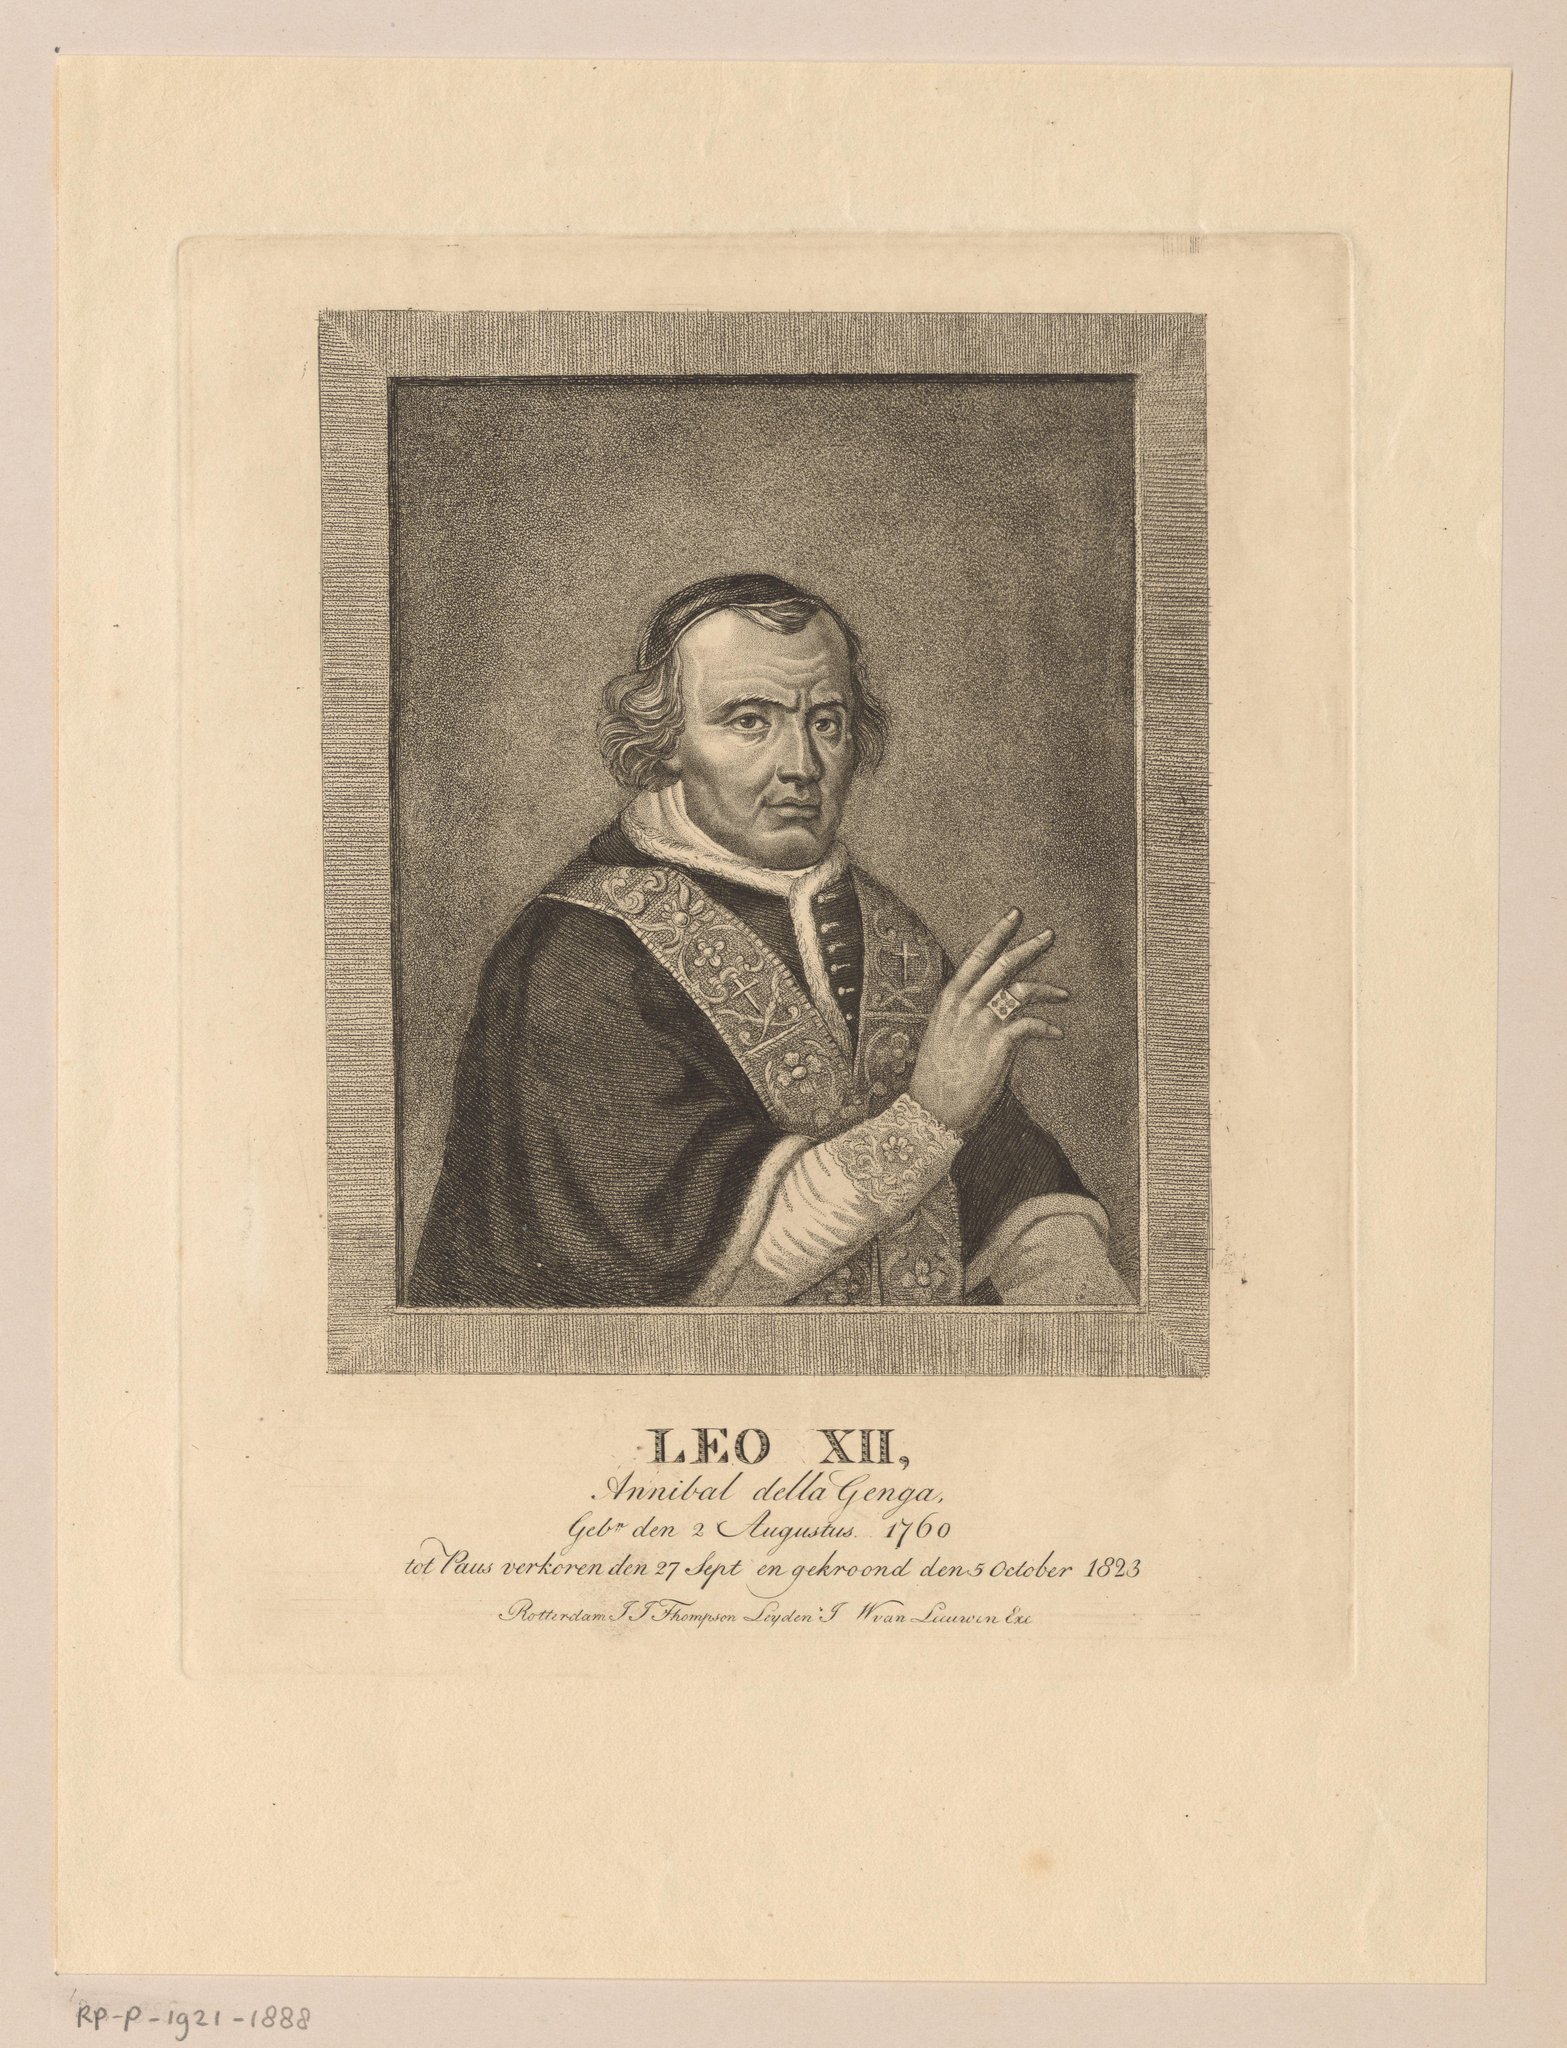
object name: print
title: Portret van Leo XII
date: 1823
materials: paper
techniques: aquatint, etching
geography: netherlands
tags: historical persons, pope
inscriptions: collector's mark: Lugt 2233